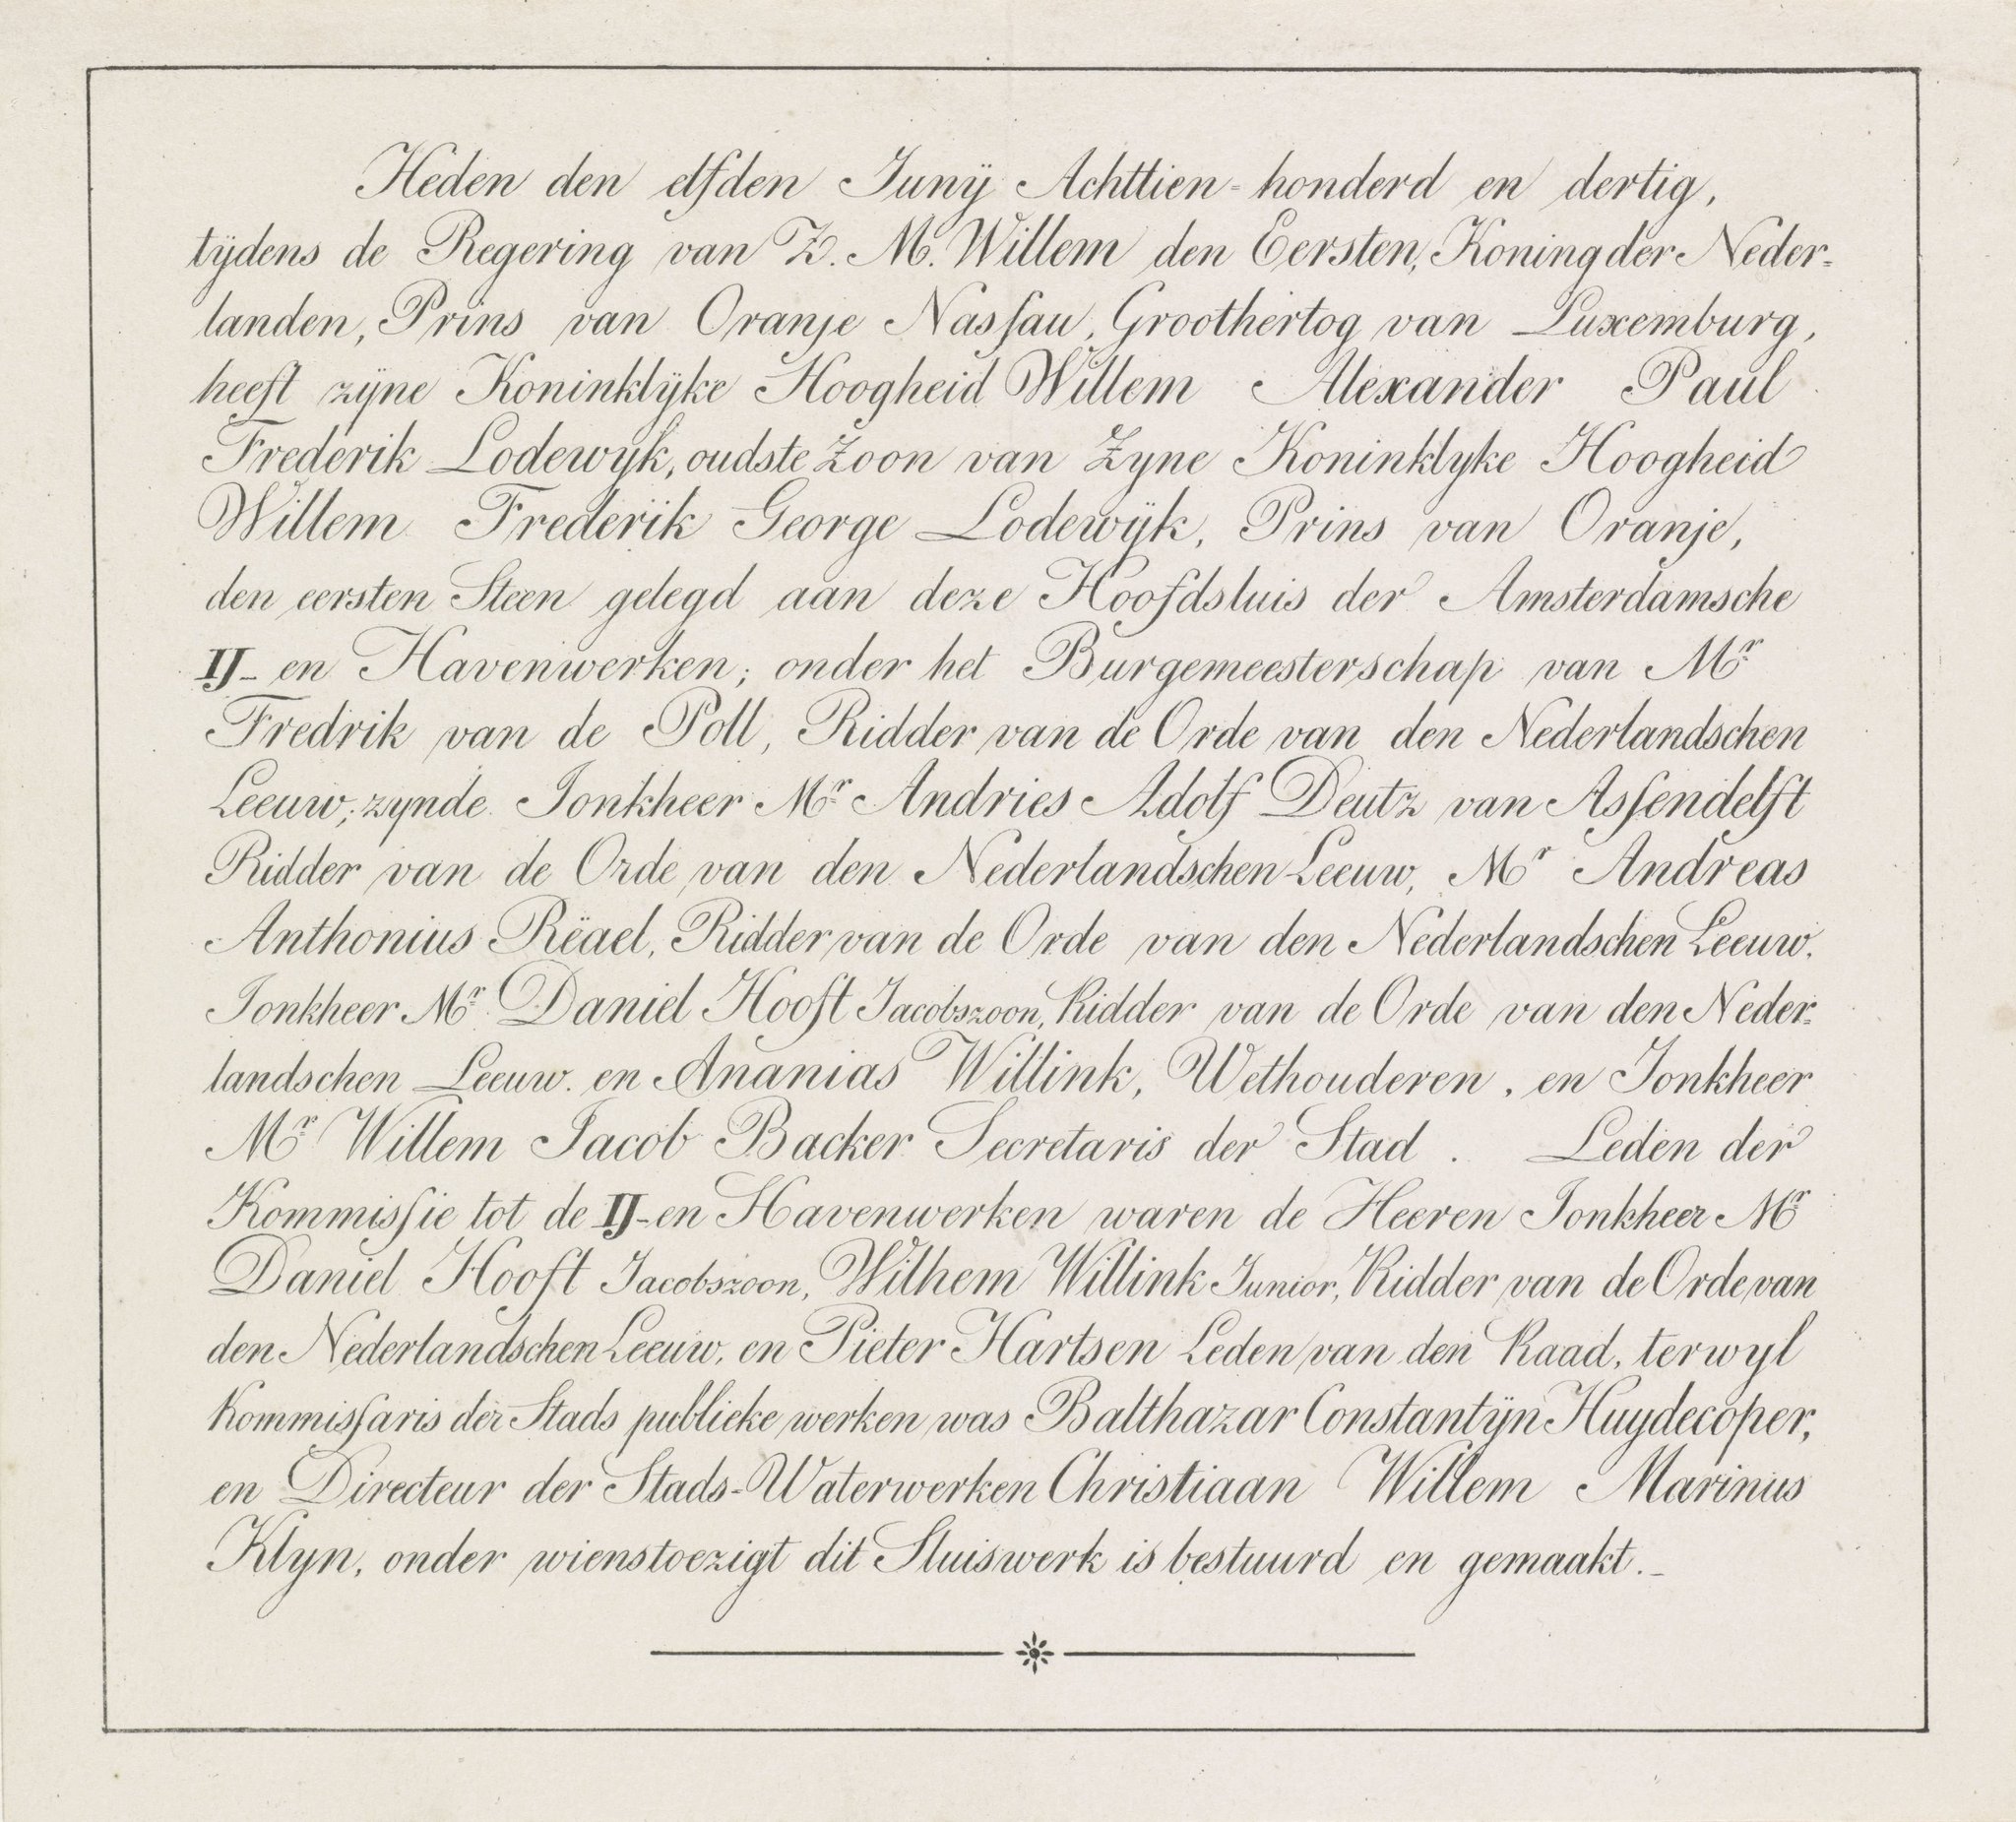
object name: print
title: Koperen plaat ingemetseld bij de legging van de eerste steen van de Oosterdoksdijk voor Amsterdam, 1830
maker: Anonymous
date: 1830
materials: paper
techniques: etching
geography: netherlands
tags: oosterdok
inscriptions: collector's mark: Lugt 2228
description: Afdruk van de inscriptie op de koperen plaat ingemetseld bij de legging van de eerste steen van de hoofdsluis der Amsterdamsche IJ- en Havenwerken aan de Oosterdoksdijk voor Amsterdam door de kroonprins op 11 juni 1830.